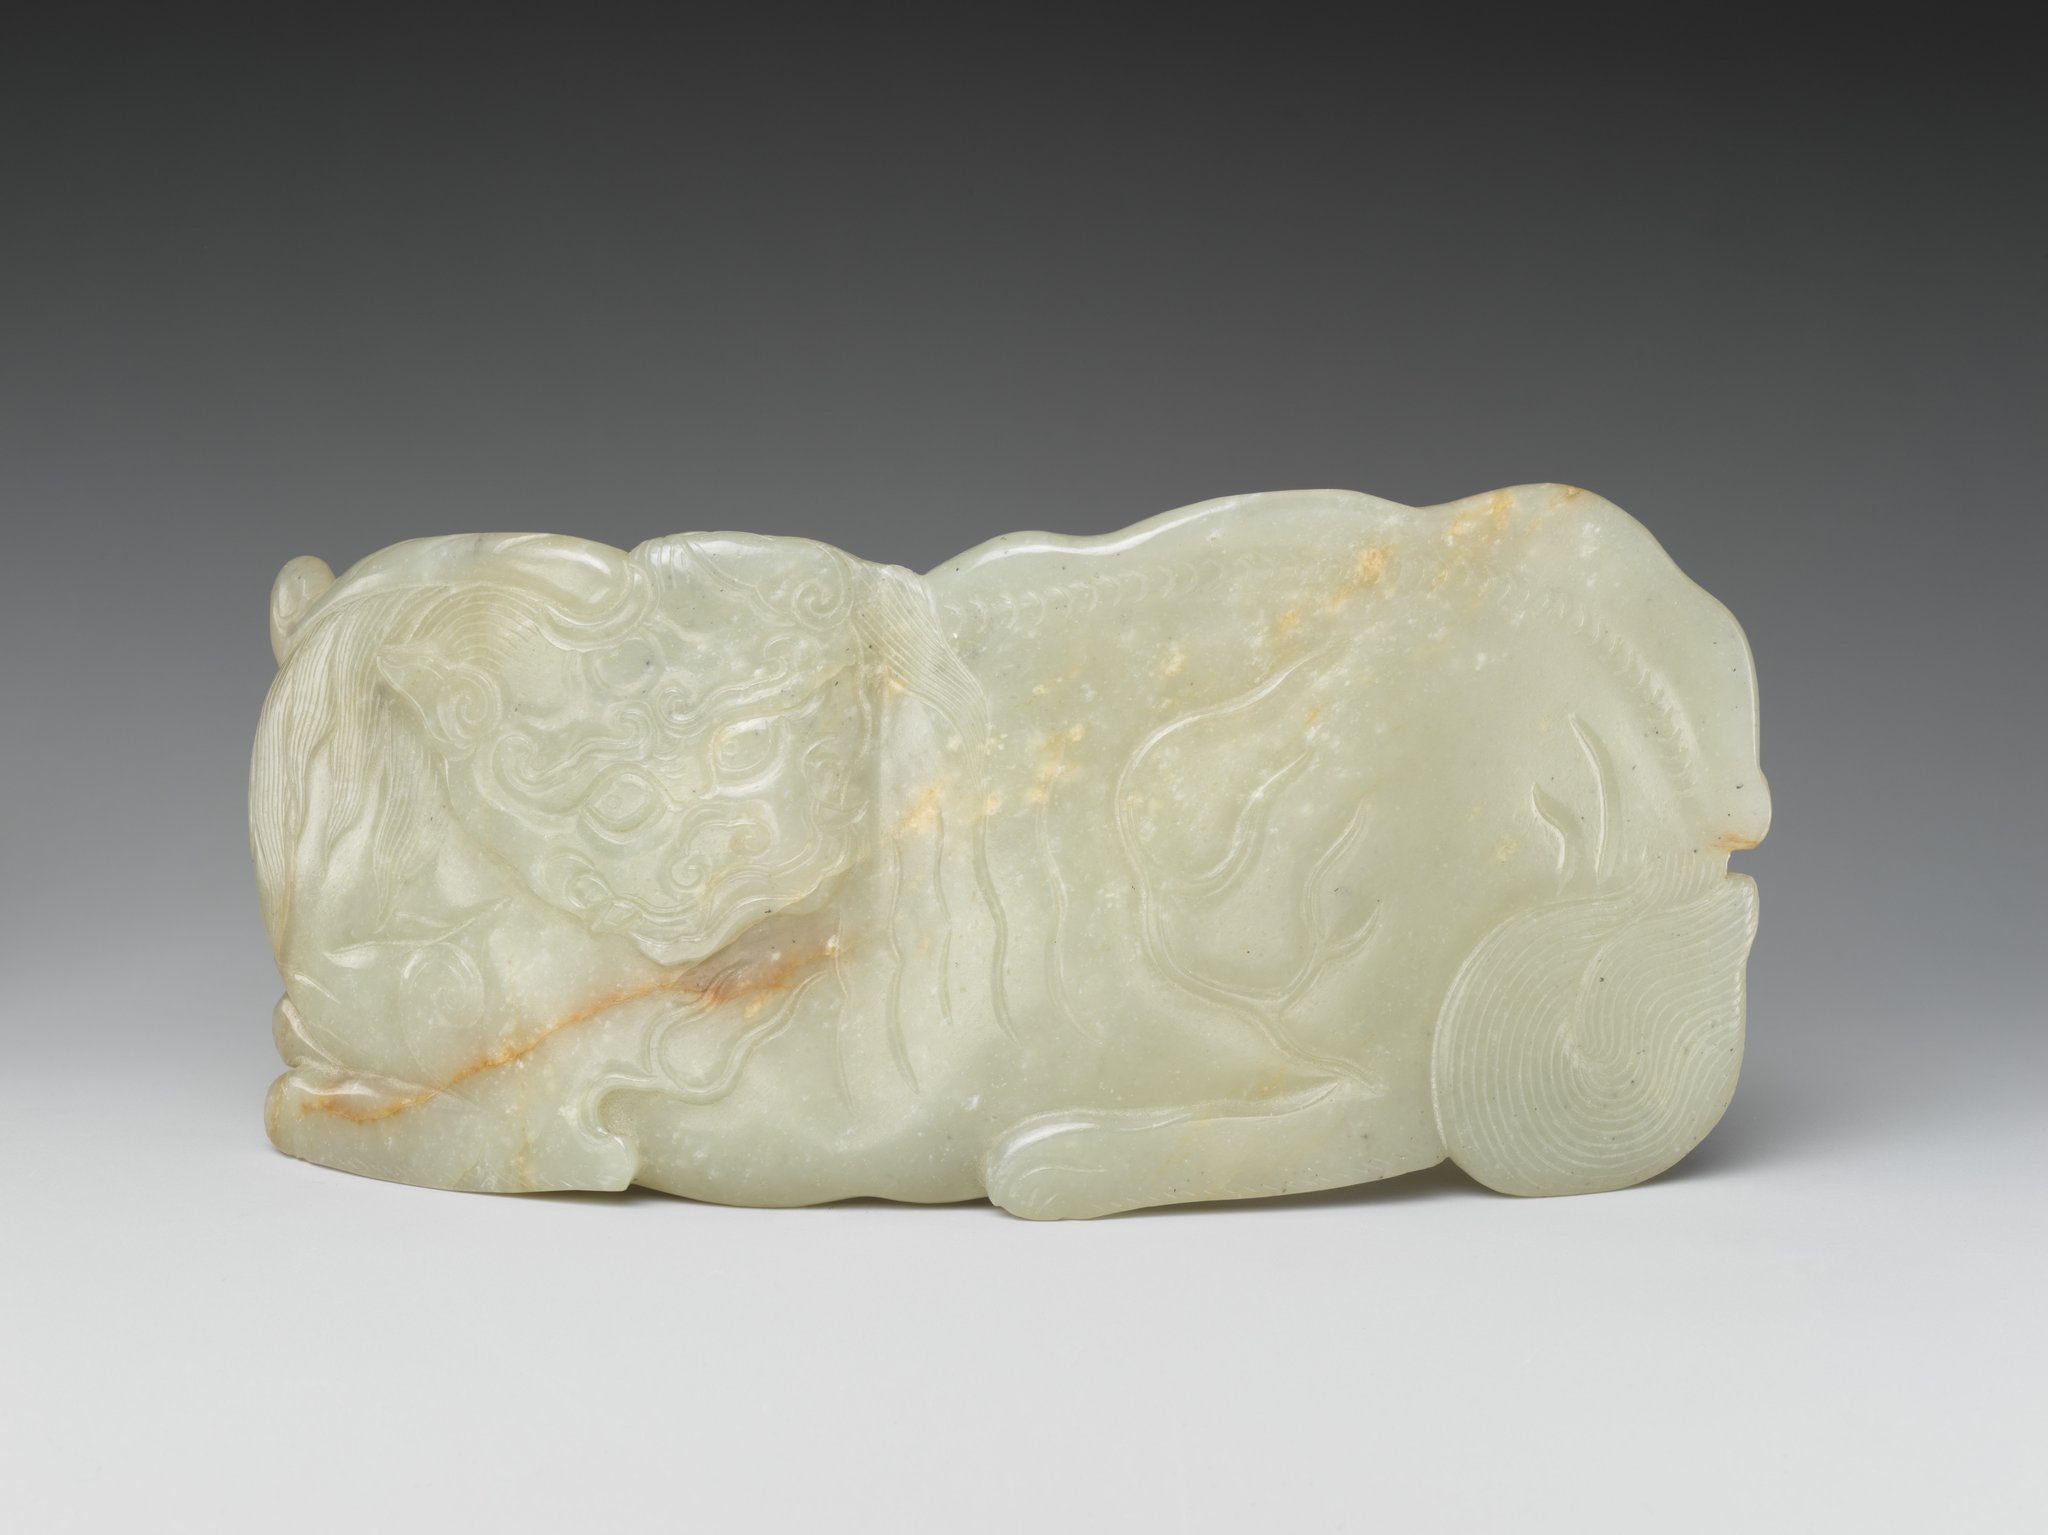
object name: carving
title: Carving with mythical beast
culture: chinese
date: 1501-1700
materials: jade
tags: mythical creatures